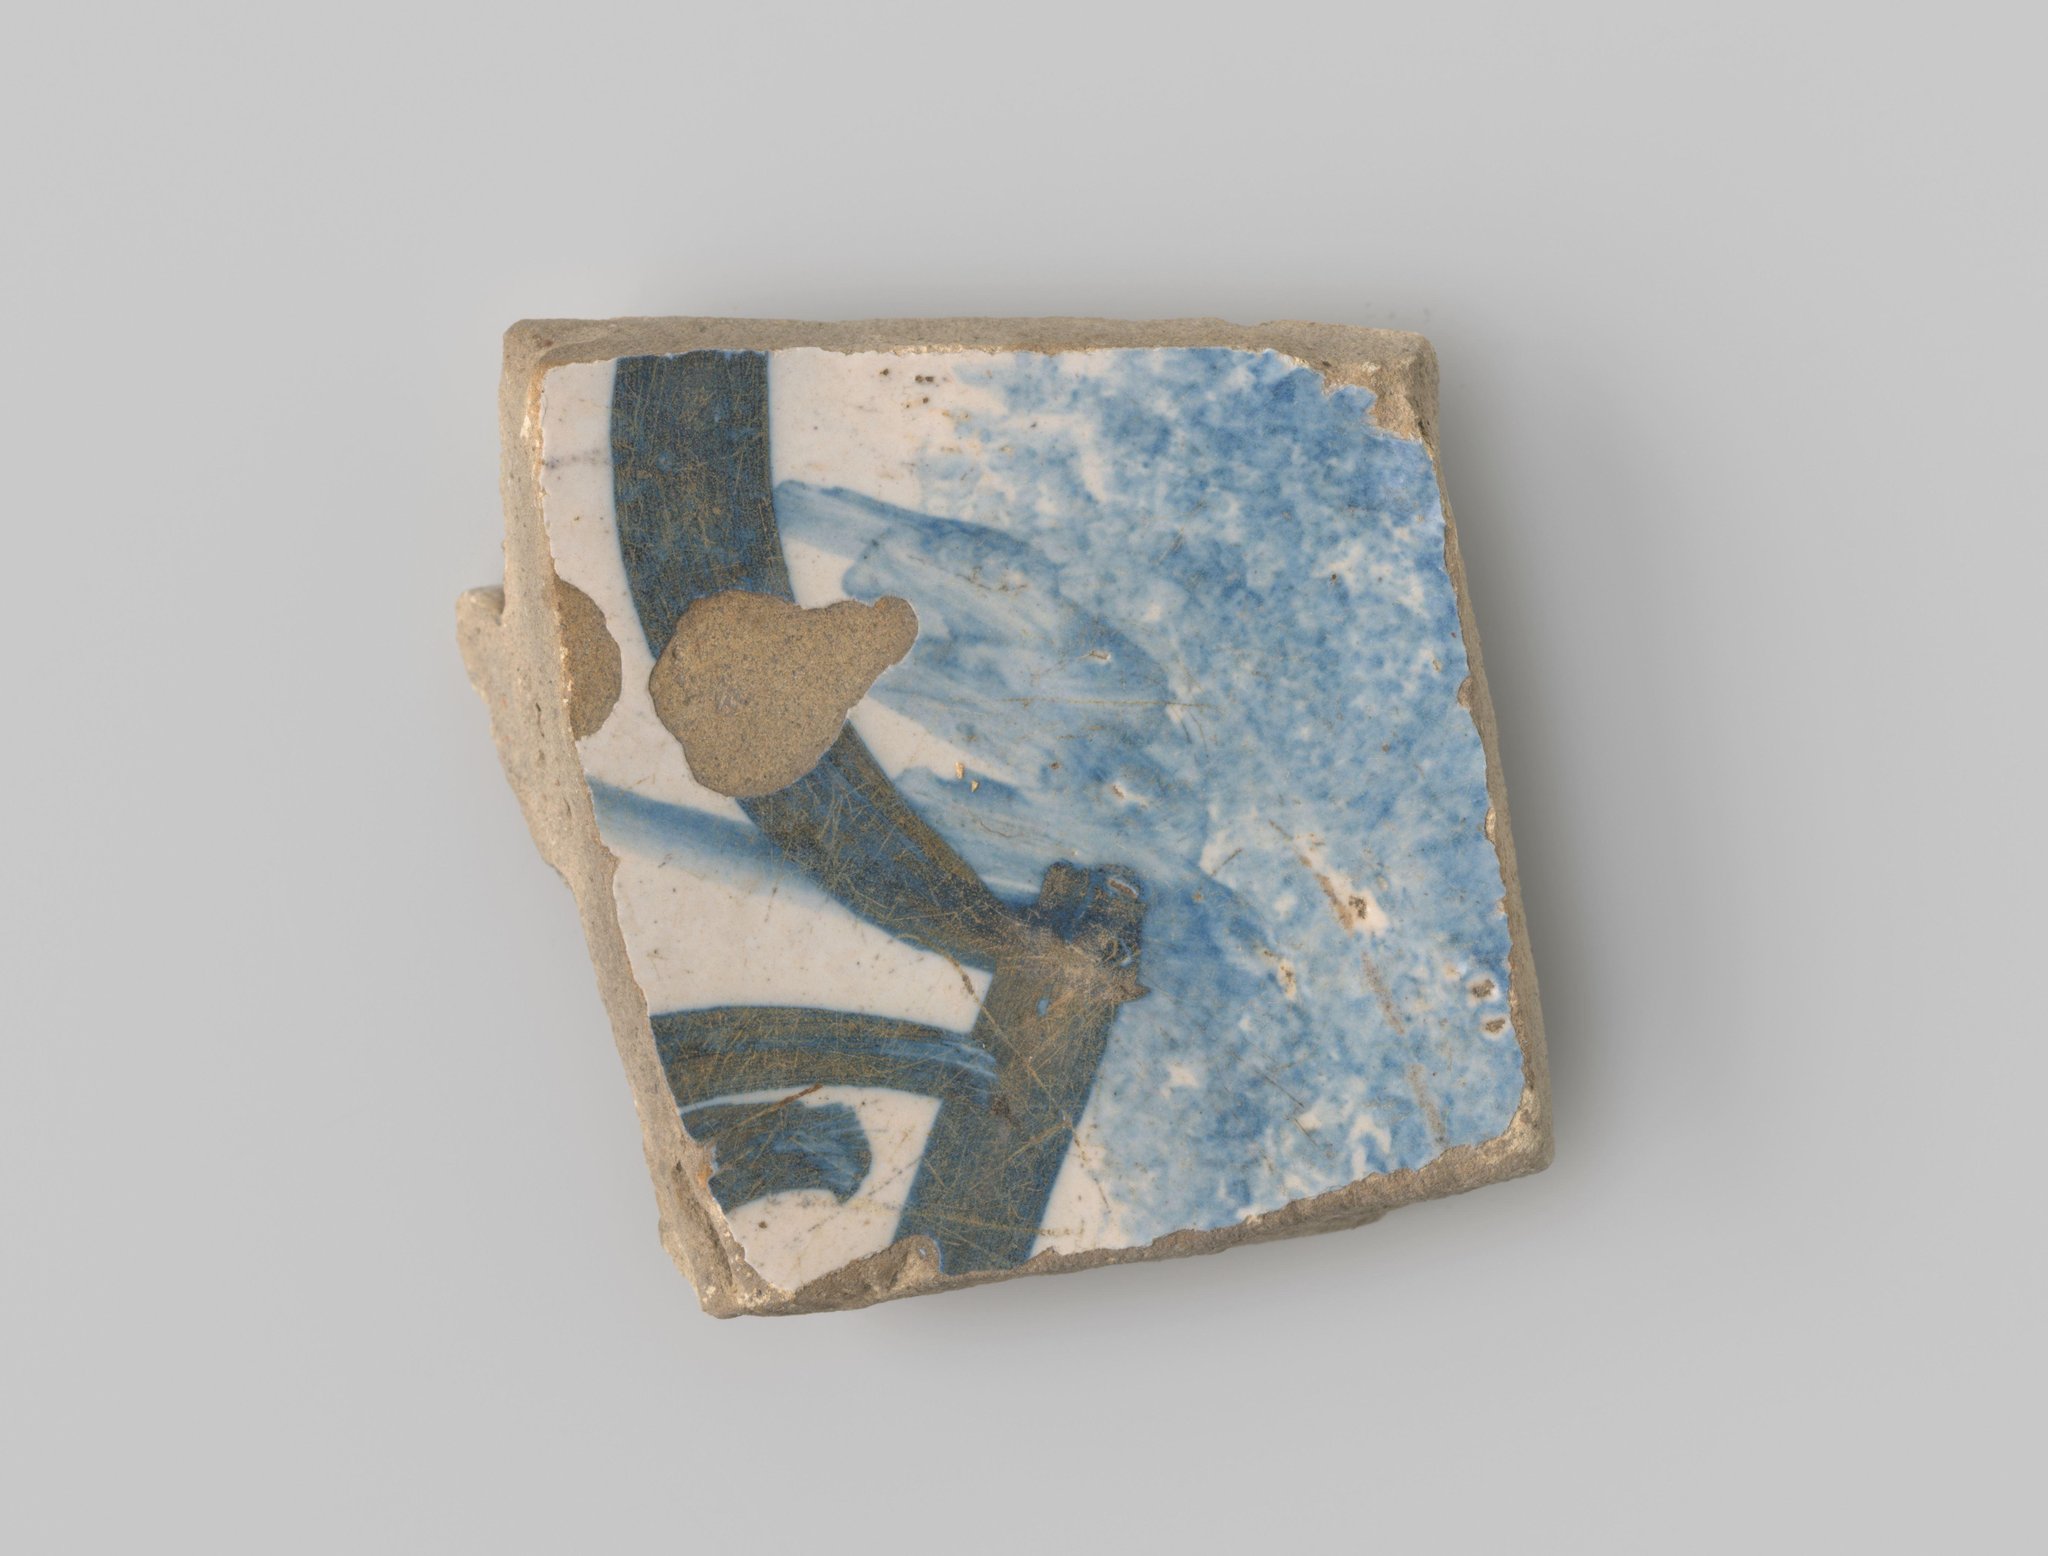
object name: sherd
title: Scherf van rossigbakkend aardewerk, aan de buitenzijde voorzien van een beschildering in blauw op een grijze ondergrond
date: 1500-1899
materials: earthenware, glaze